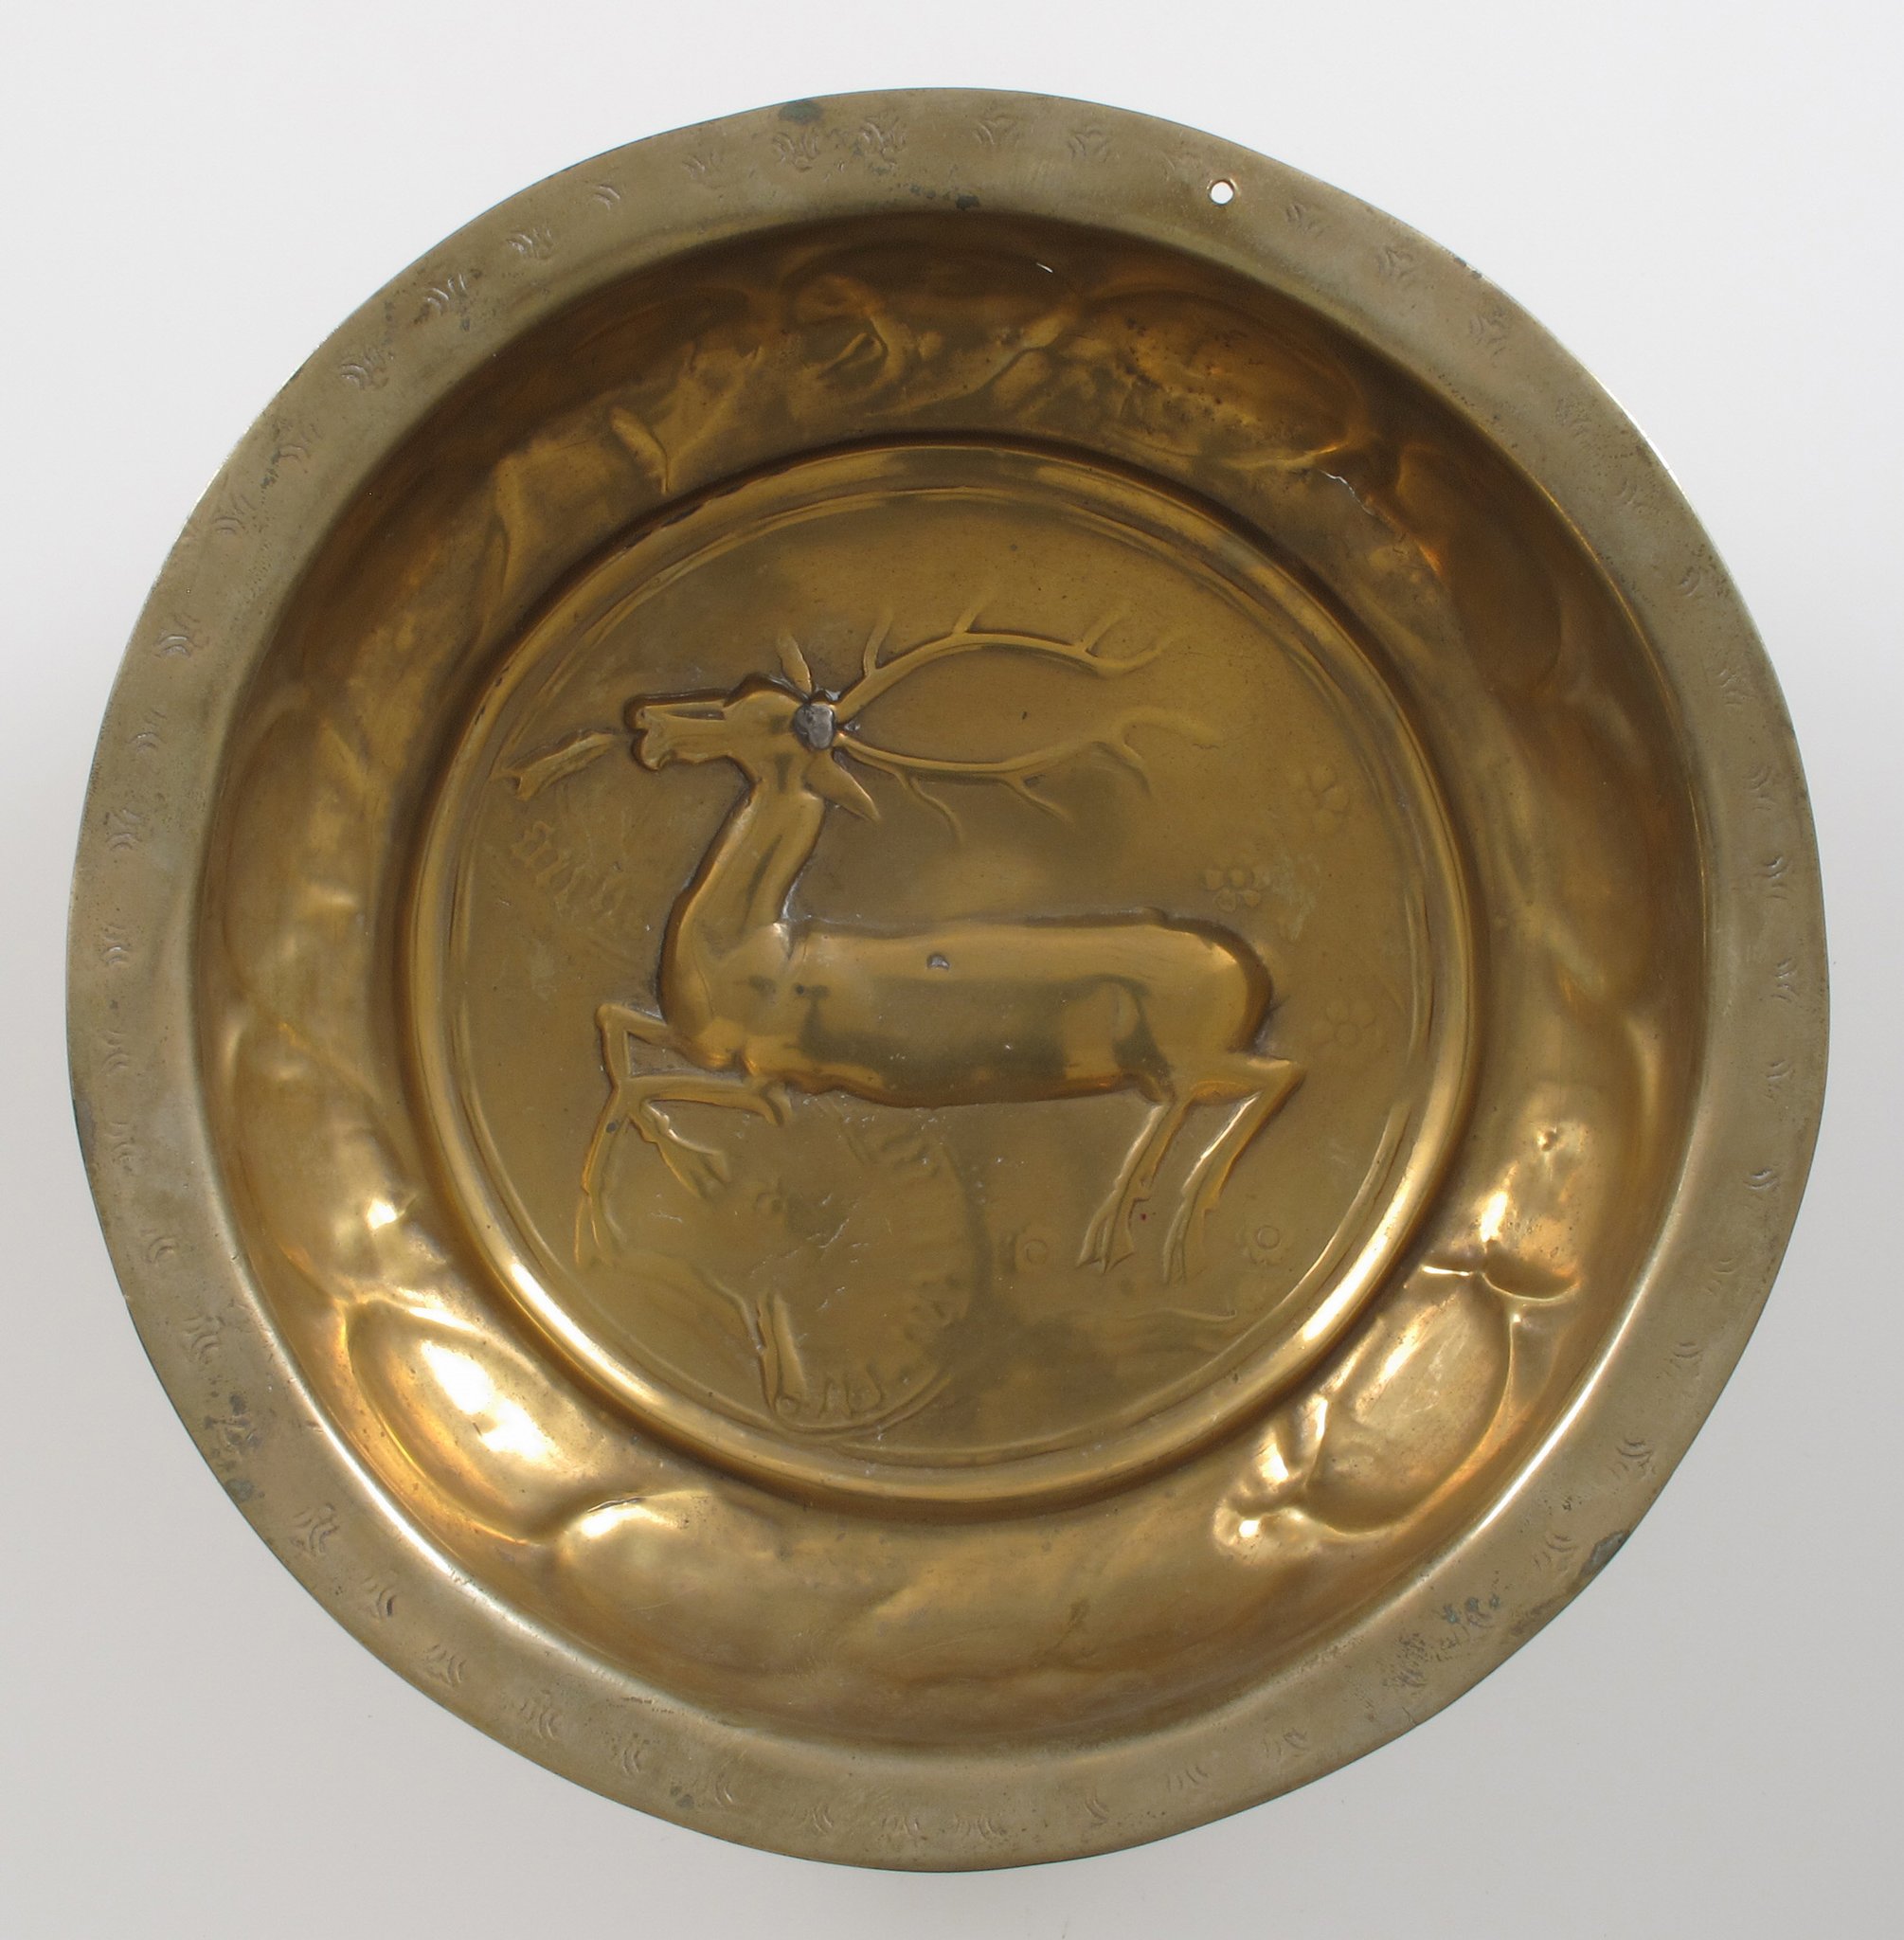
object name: dish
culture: german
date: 1501-1533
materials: brass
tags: deer